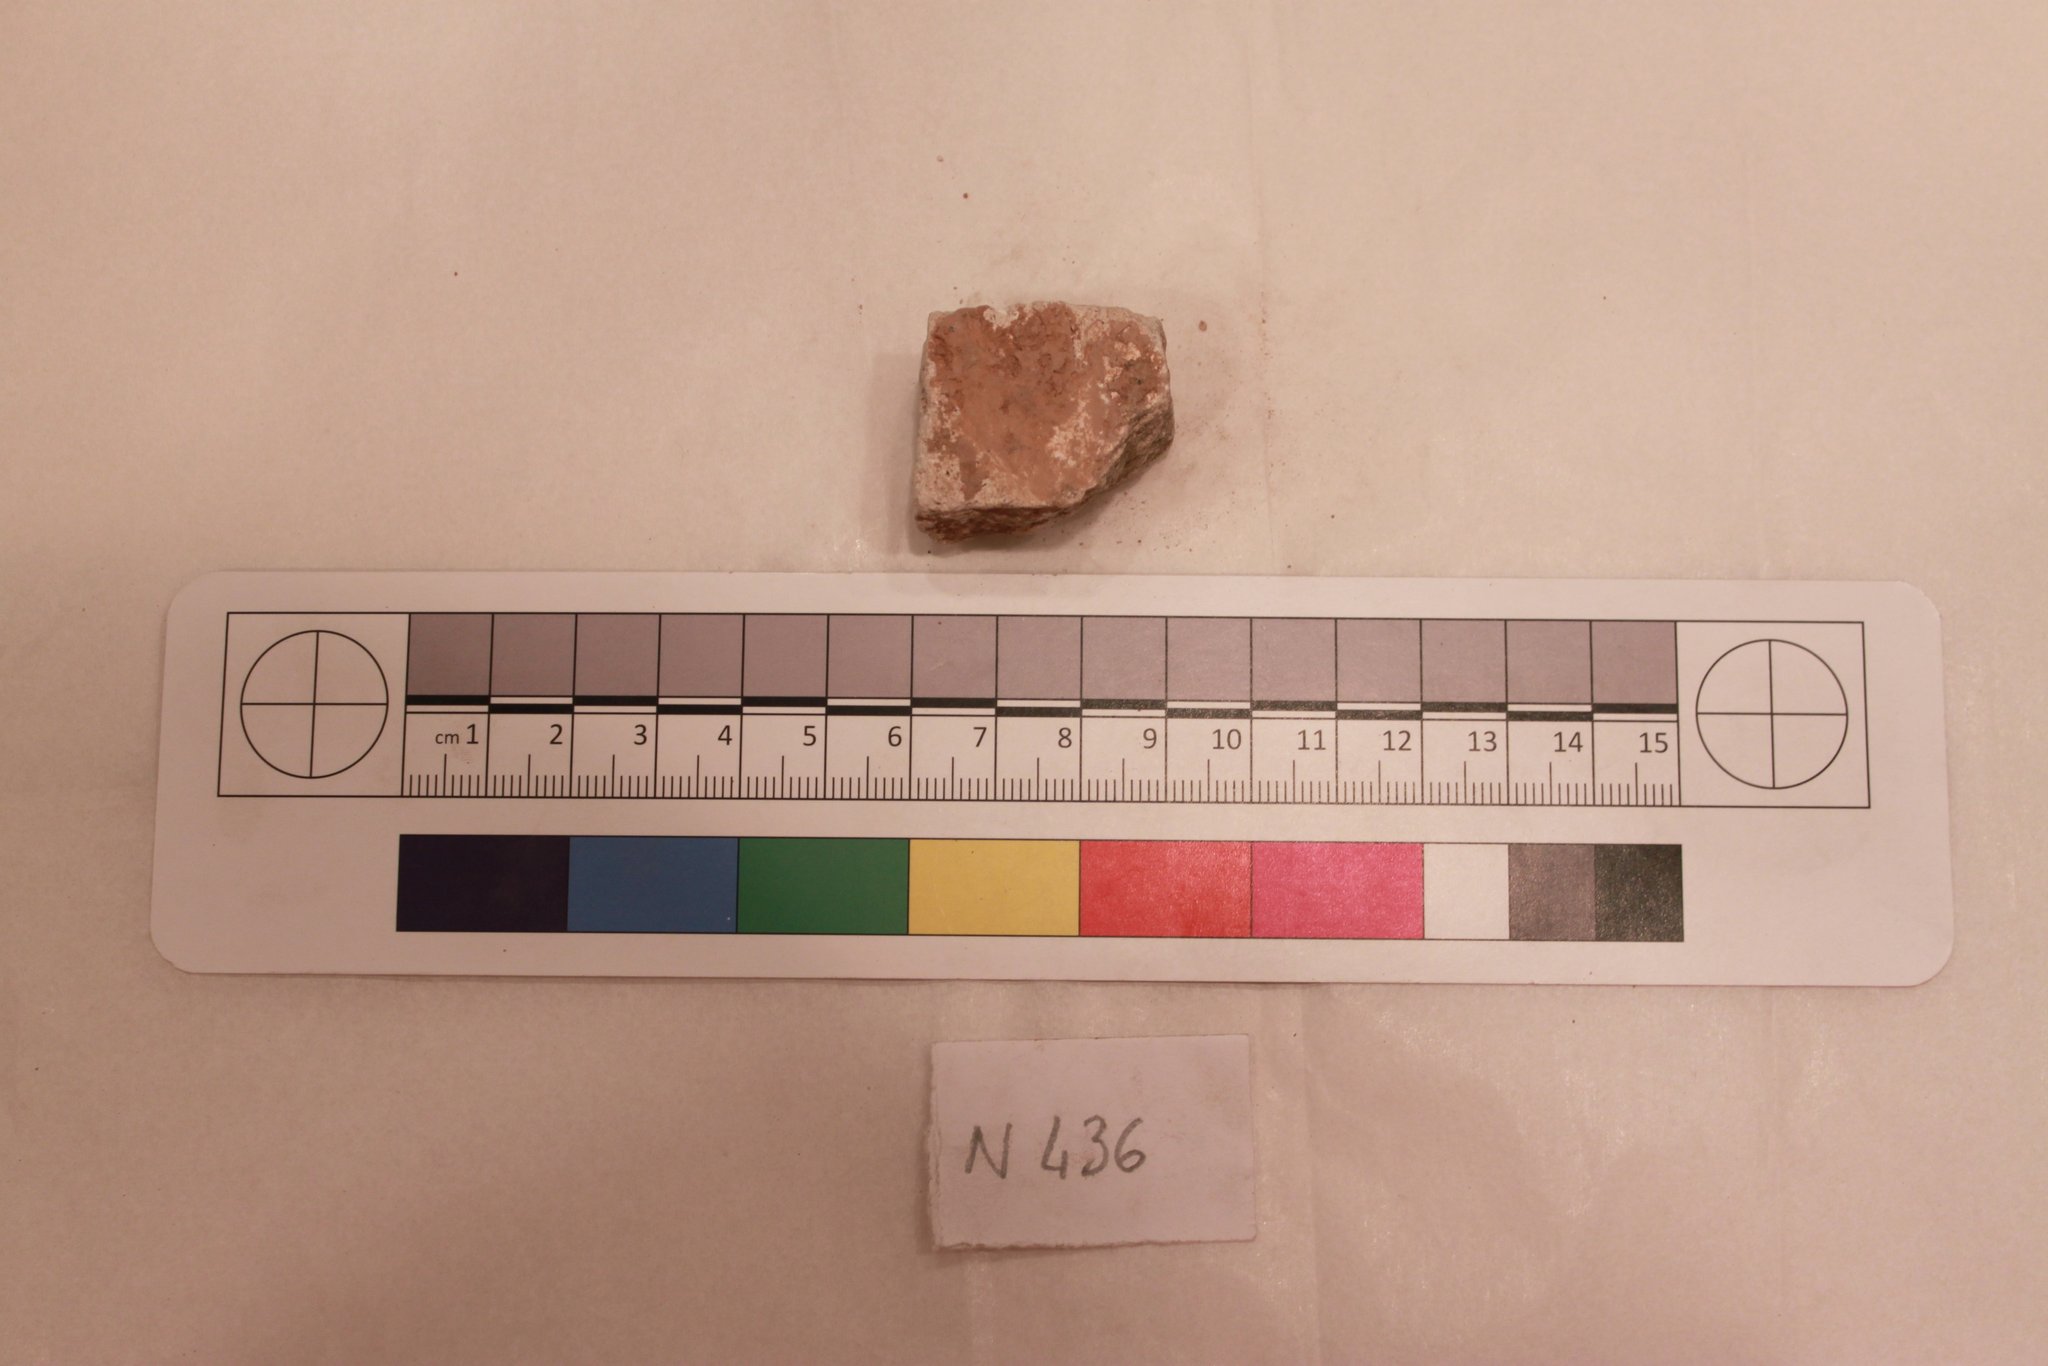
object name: fragment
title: Stucco Fragment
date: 701-1200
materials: plaster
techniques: carving, painting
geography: iran